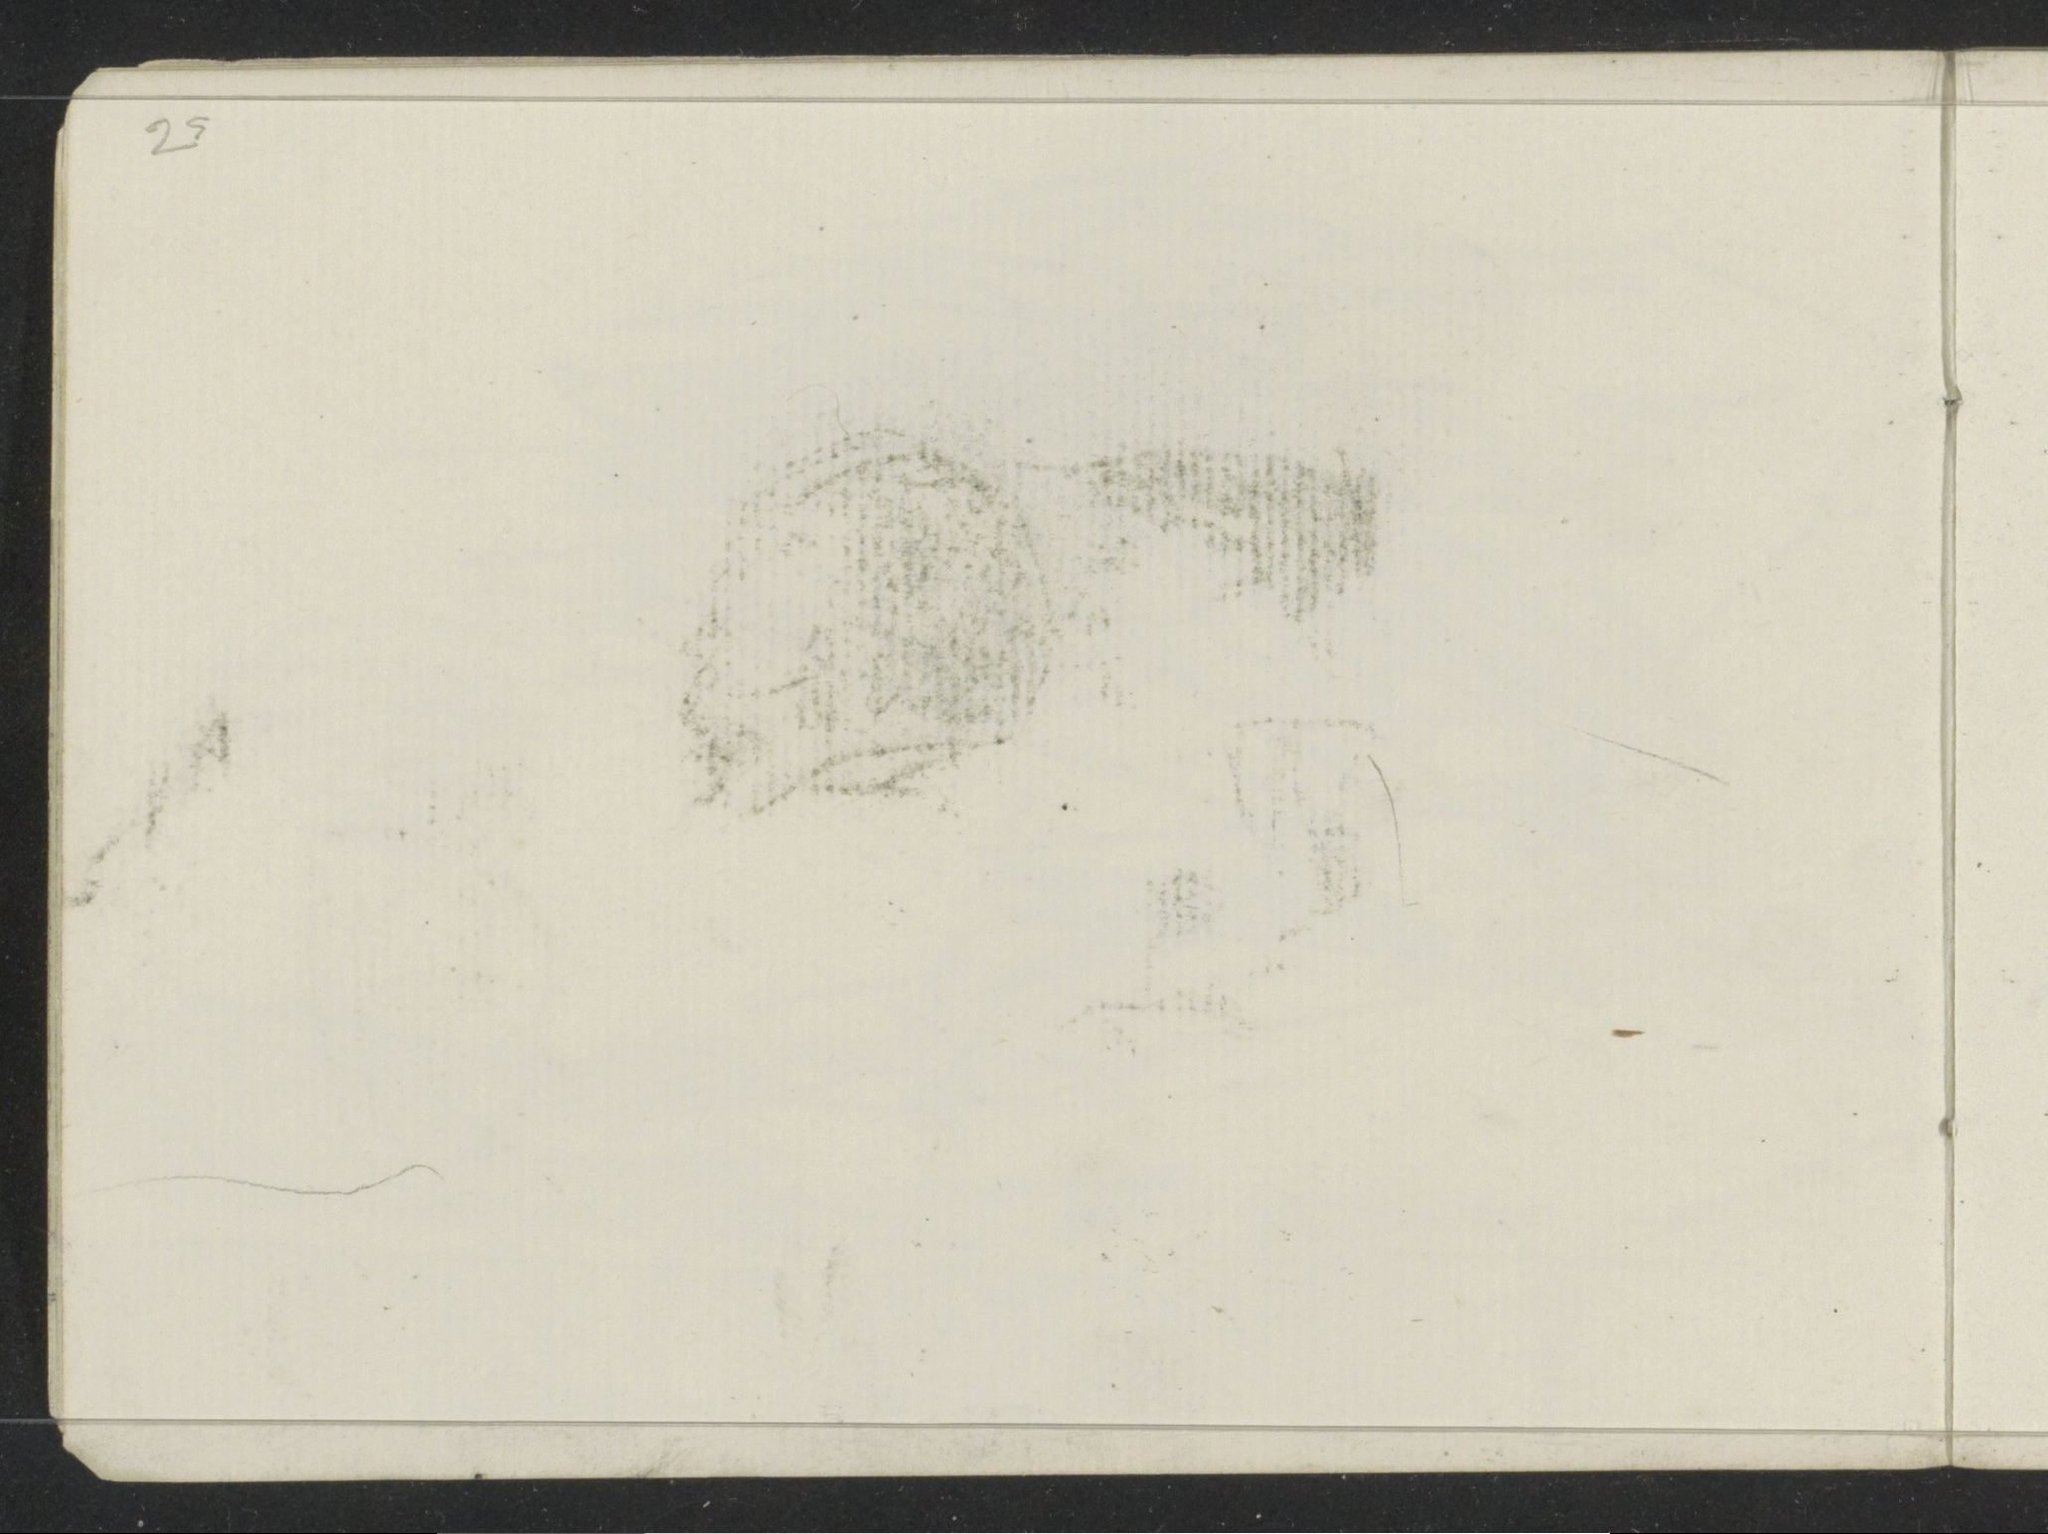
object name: sketchbook leaf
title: Abklatsch van de krijttekening op blad 4 recto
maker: isaac israels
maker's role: draughtsman, painter, print maker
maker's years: 1865-1934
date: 1886-1934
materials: paper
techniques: printmaking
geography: amsterdam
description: Blad 3 verso uit schetsboek LXIV met 29 bladen.